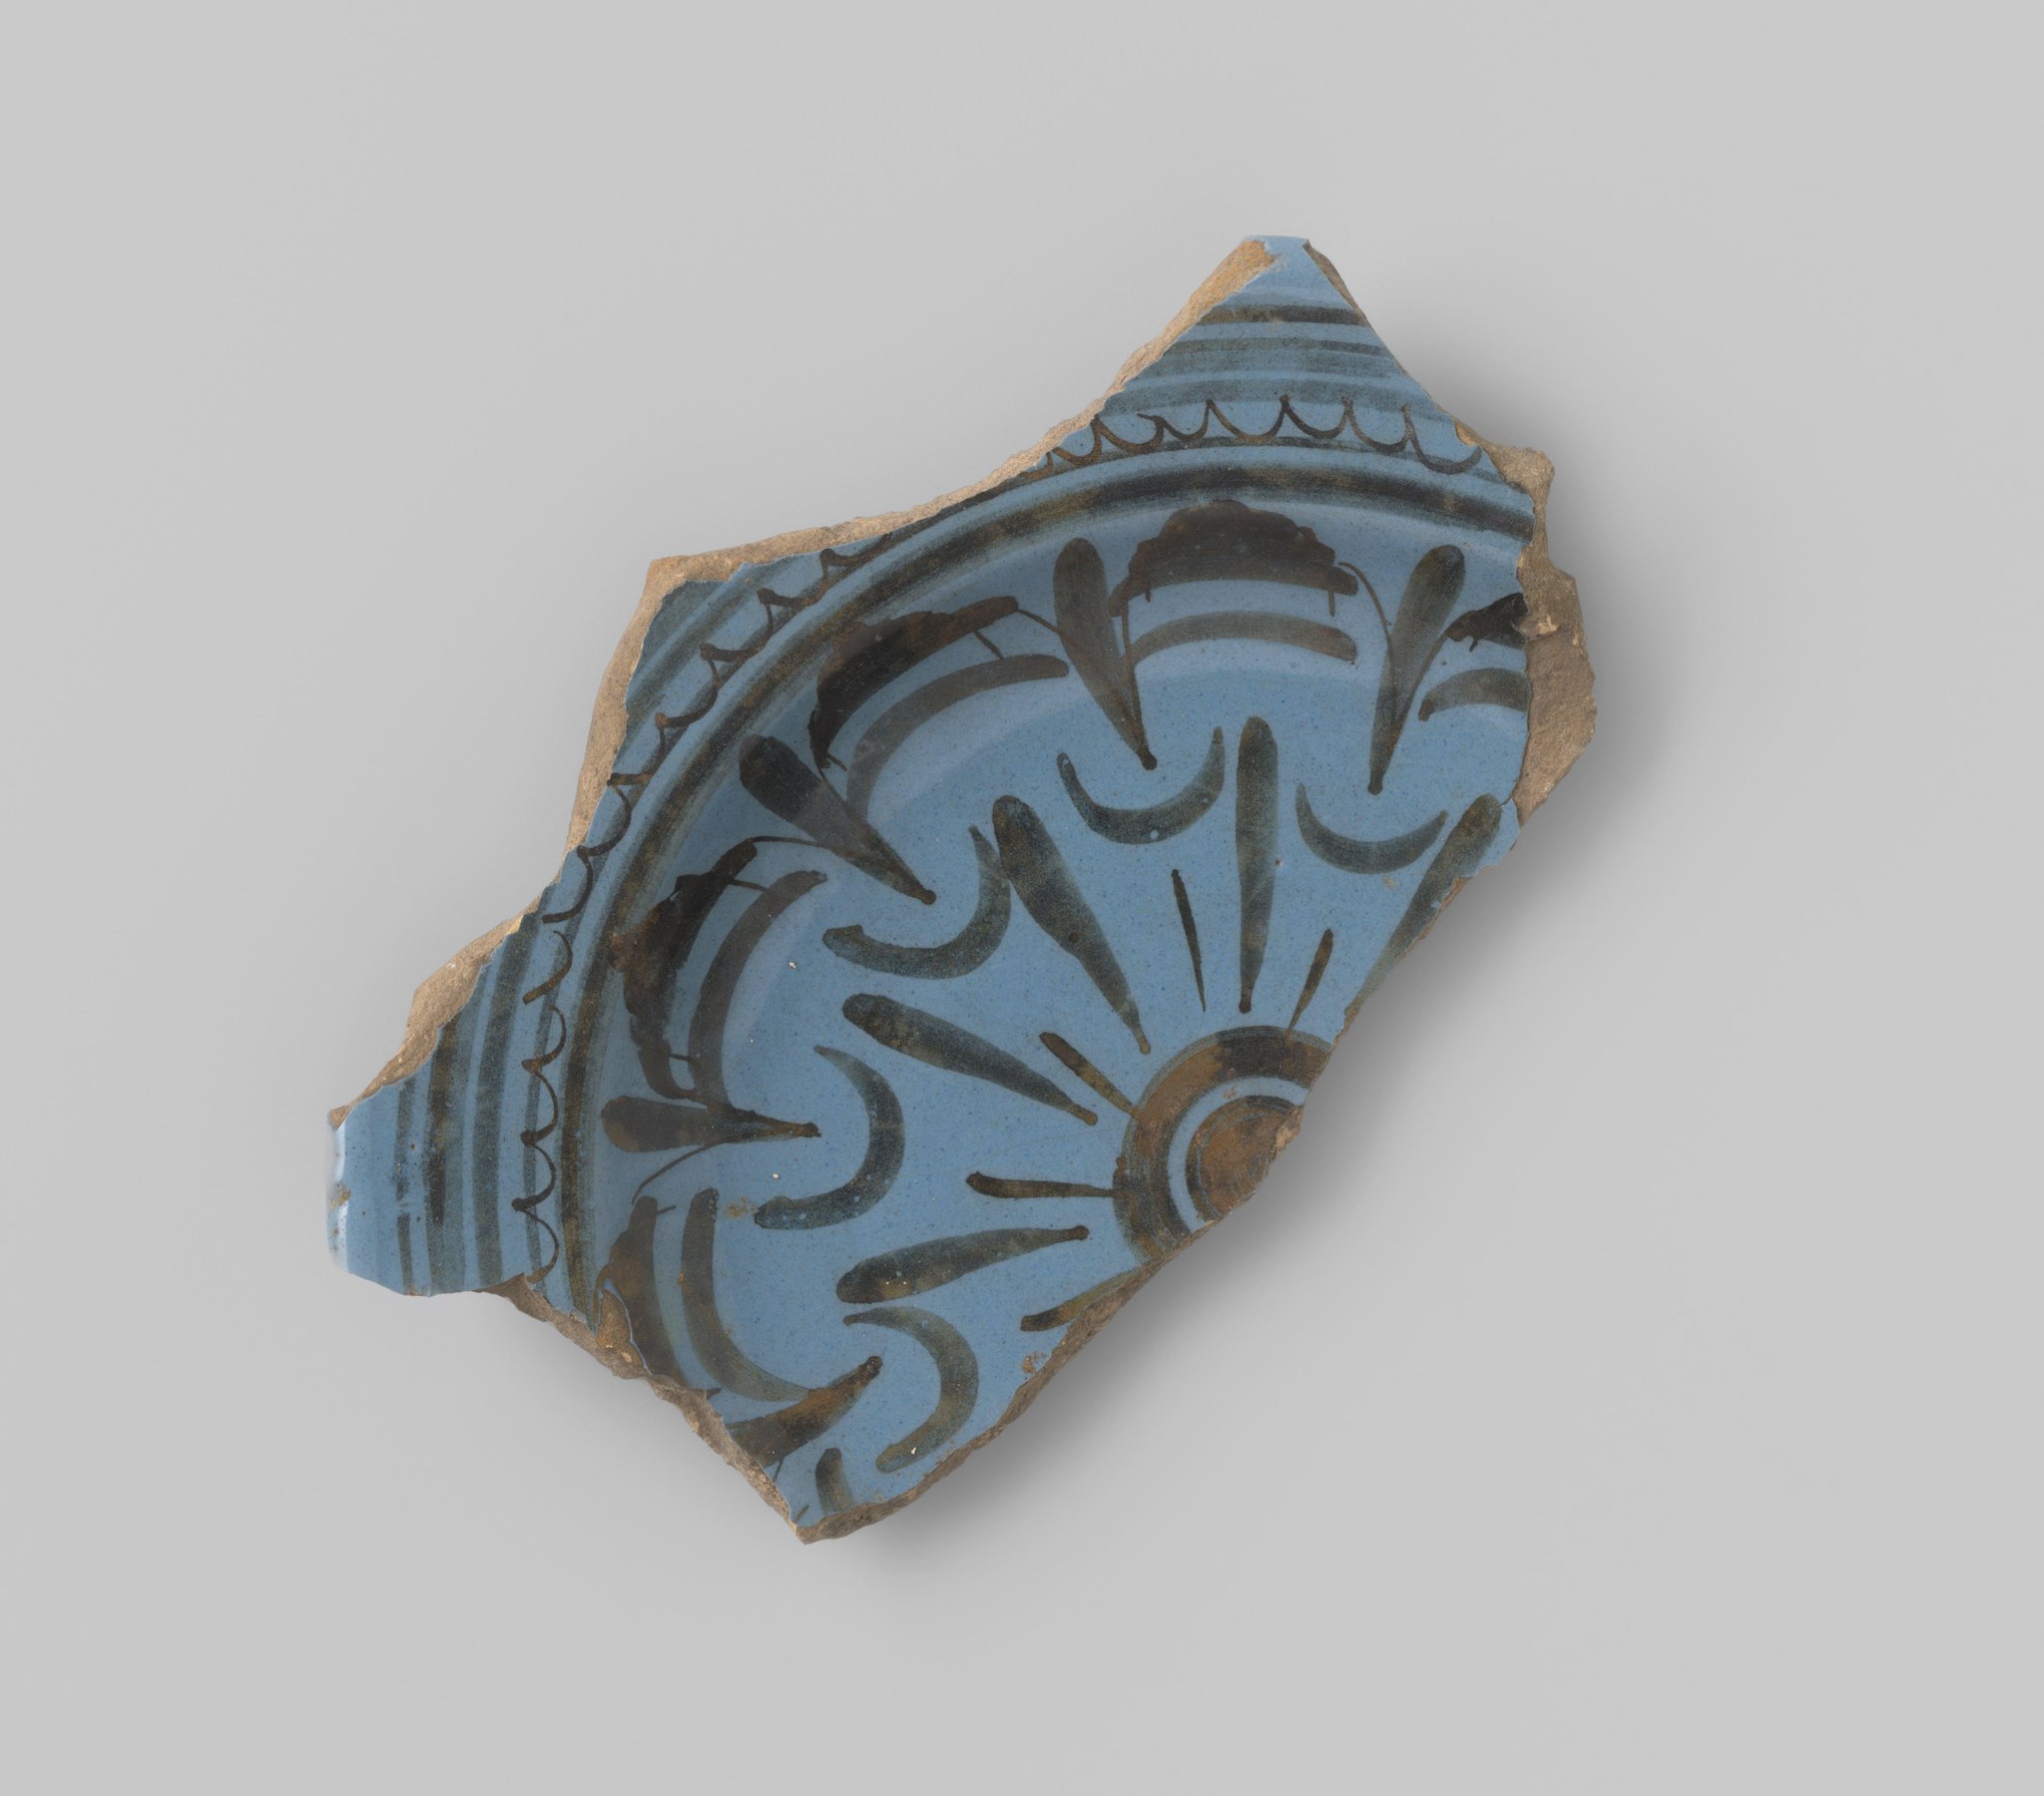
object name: fragment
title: Schotelscherf van geelbakkend aardewerk, voorzien van blauw glazuur aan de boven- en onderzijde, waarop een schildering van florale vormen op het plat en strepen en een gegolfde lijn op de rand, en op de achterzijde een patroon van halve cirkels in zwart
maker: Anonymous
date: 1500-1699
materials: earthenware, glaze